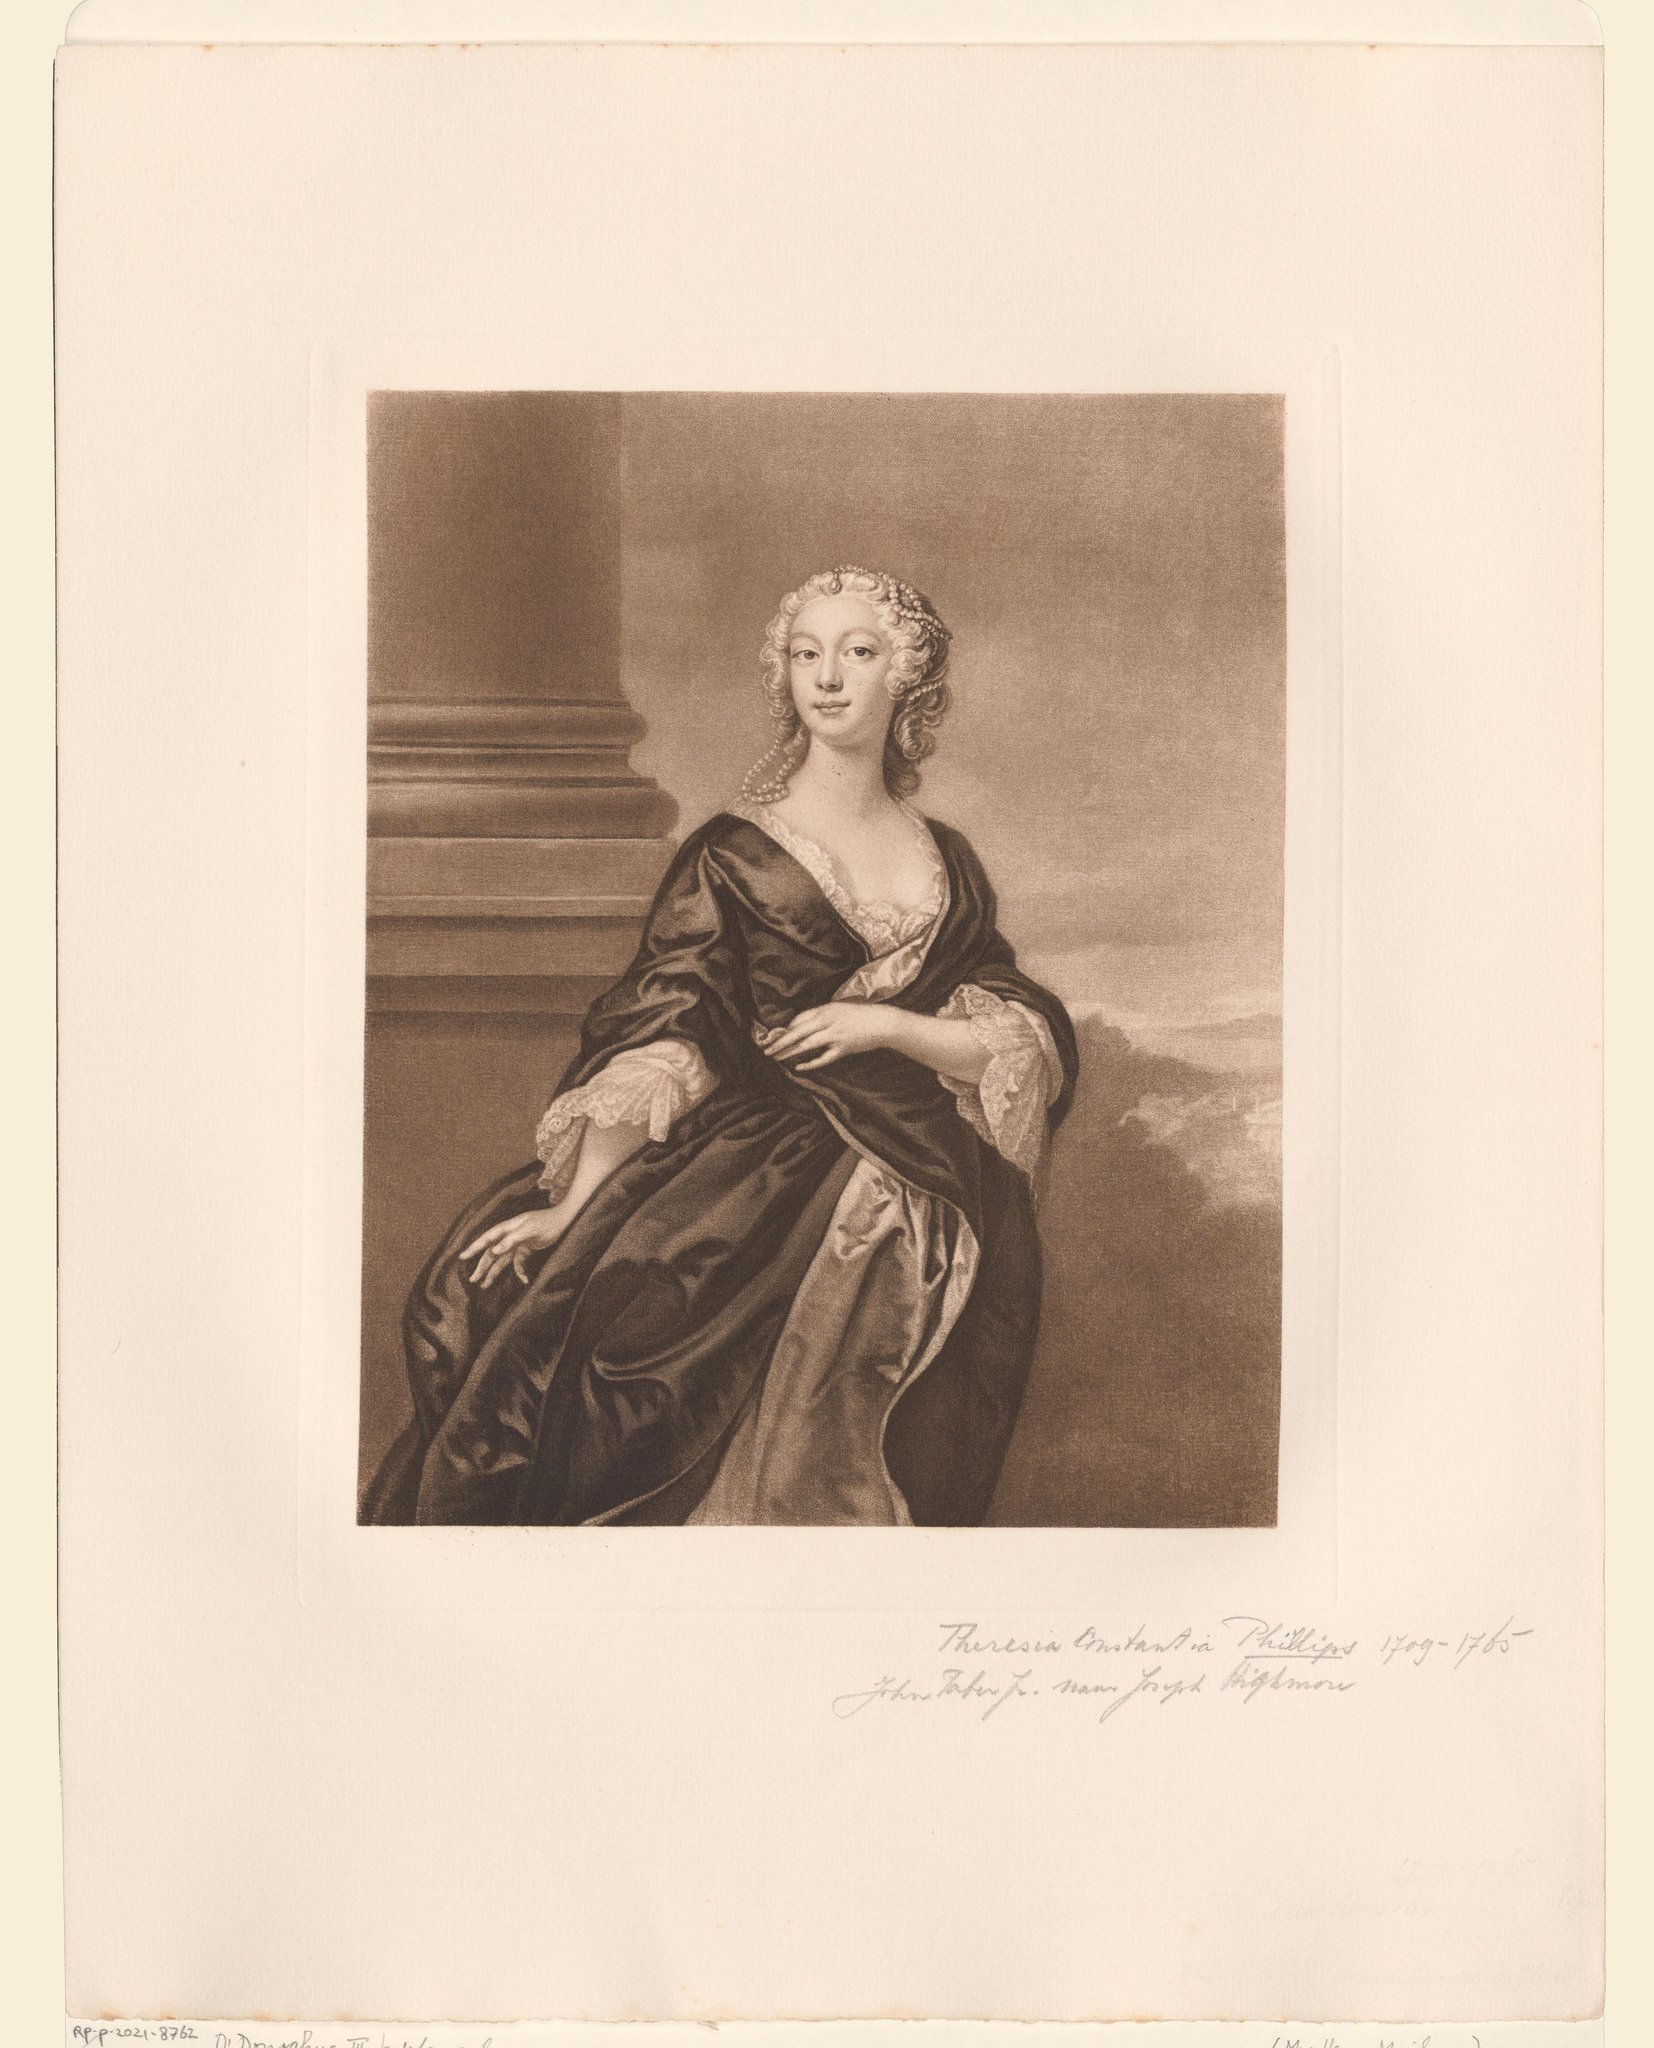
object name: photomechanical print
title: Portret van Teresia Constantia Phillips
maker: Anonymous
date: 1725-1774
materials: paper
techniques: photoaquatint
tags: adult woman, column, pillar ~ architecture, historical persons